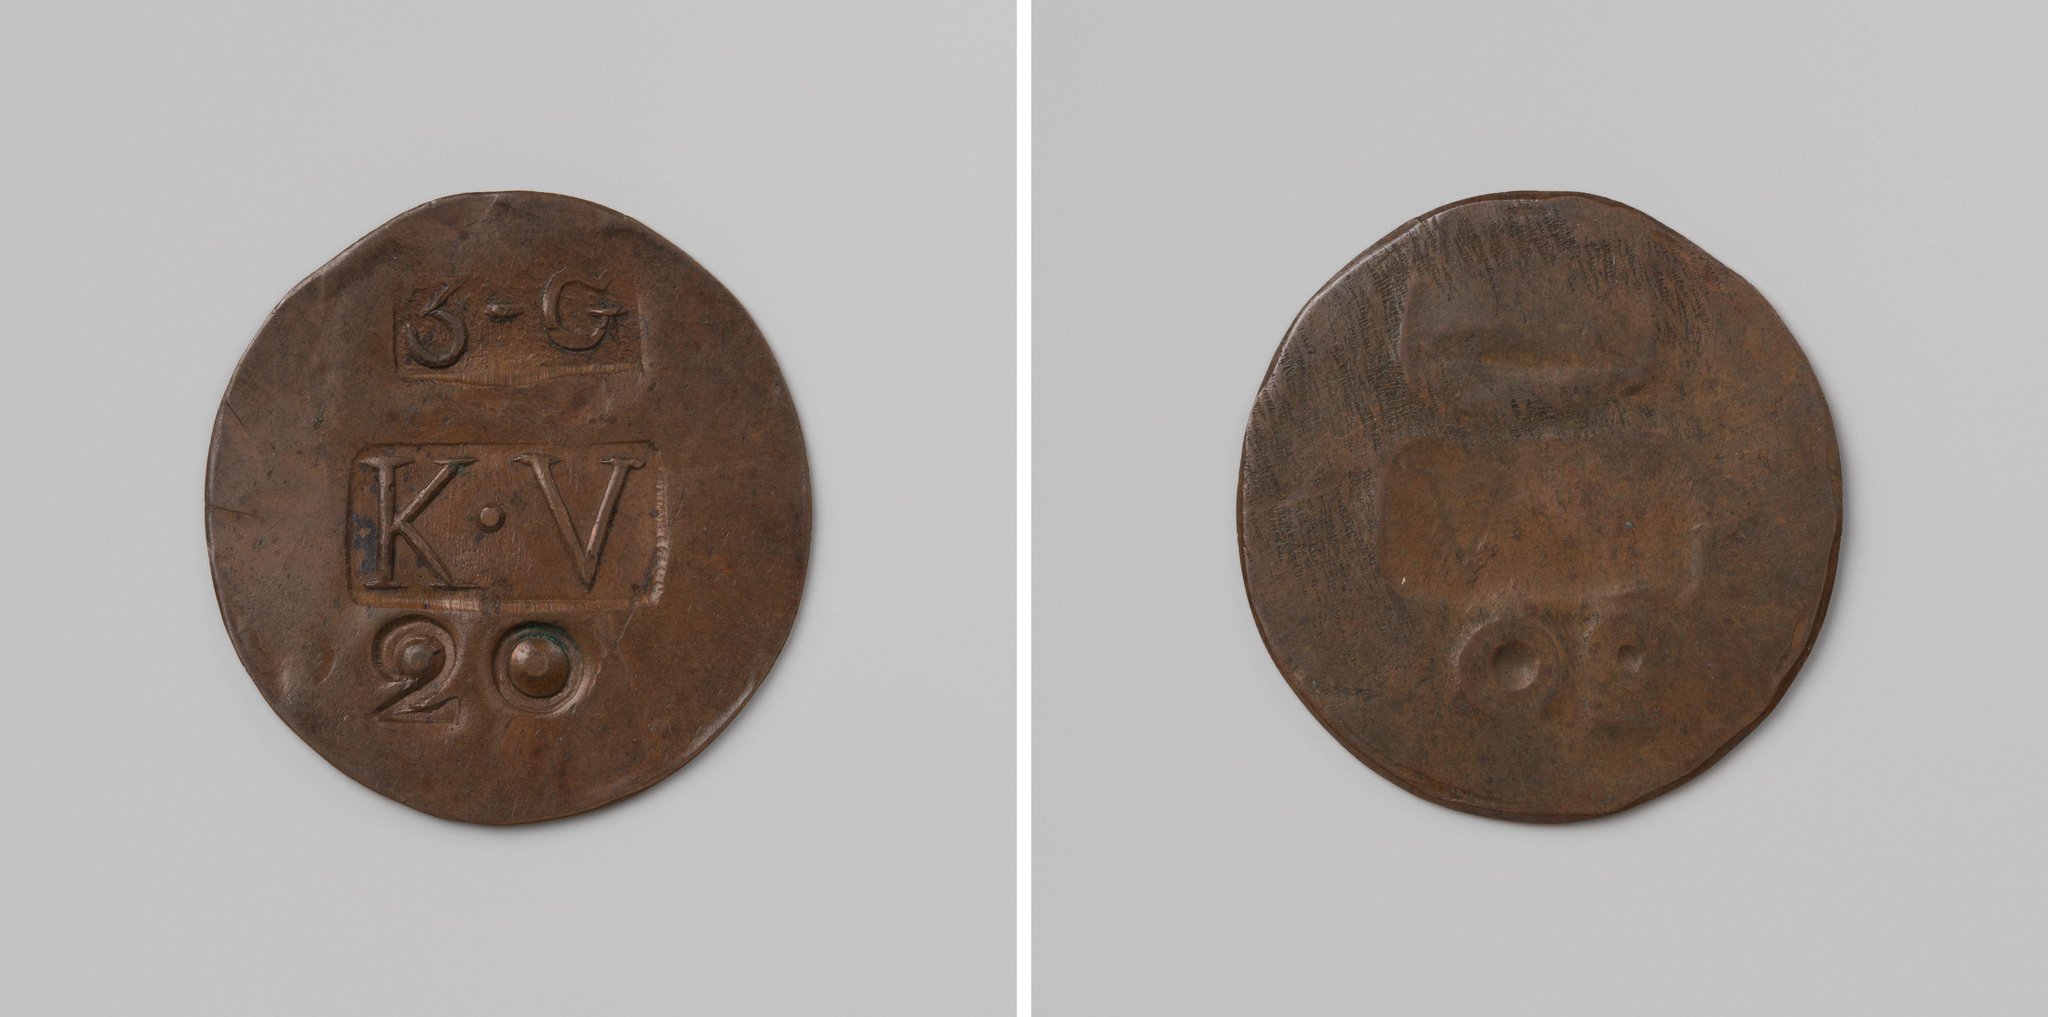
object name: monetary token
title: Derde gesticht van de kolonie Veenhuizen, huismunt huismunt van twintig cent, geslagen op last van de Maatschappij van Weldadigheid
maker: Anonymous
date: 1818-1859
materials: copper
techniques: striking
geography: netherlands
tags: maatschappij van weldadigheid, veenhuizen